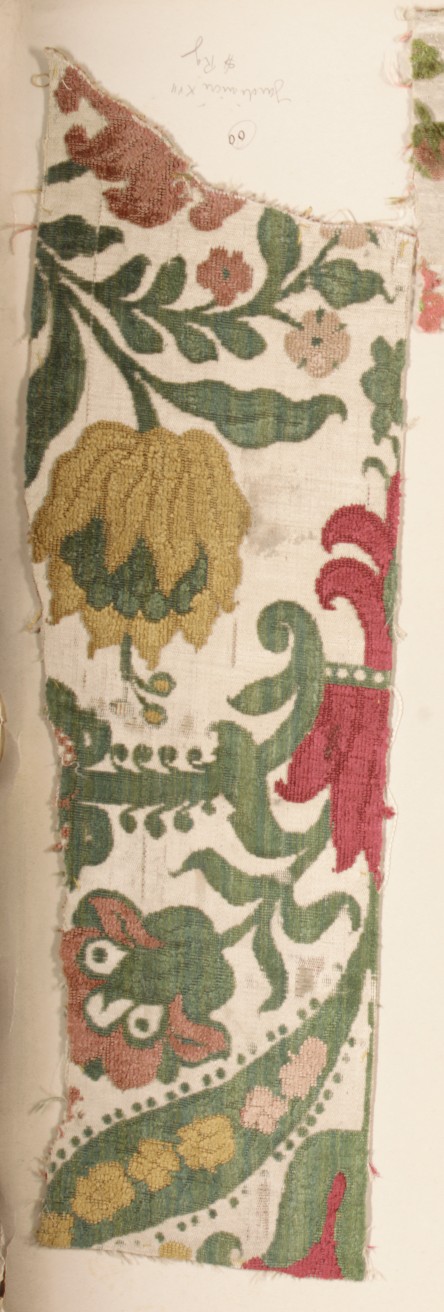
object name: fragment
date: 1601-1700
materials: silk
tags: flowers,leaves